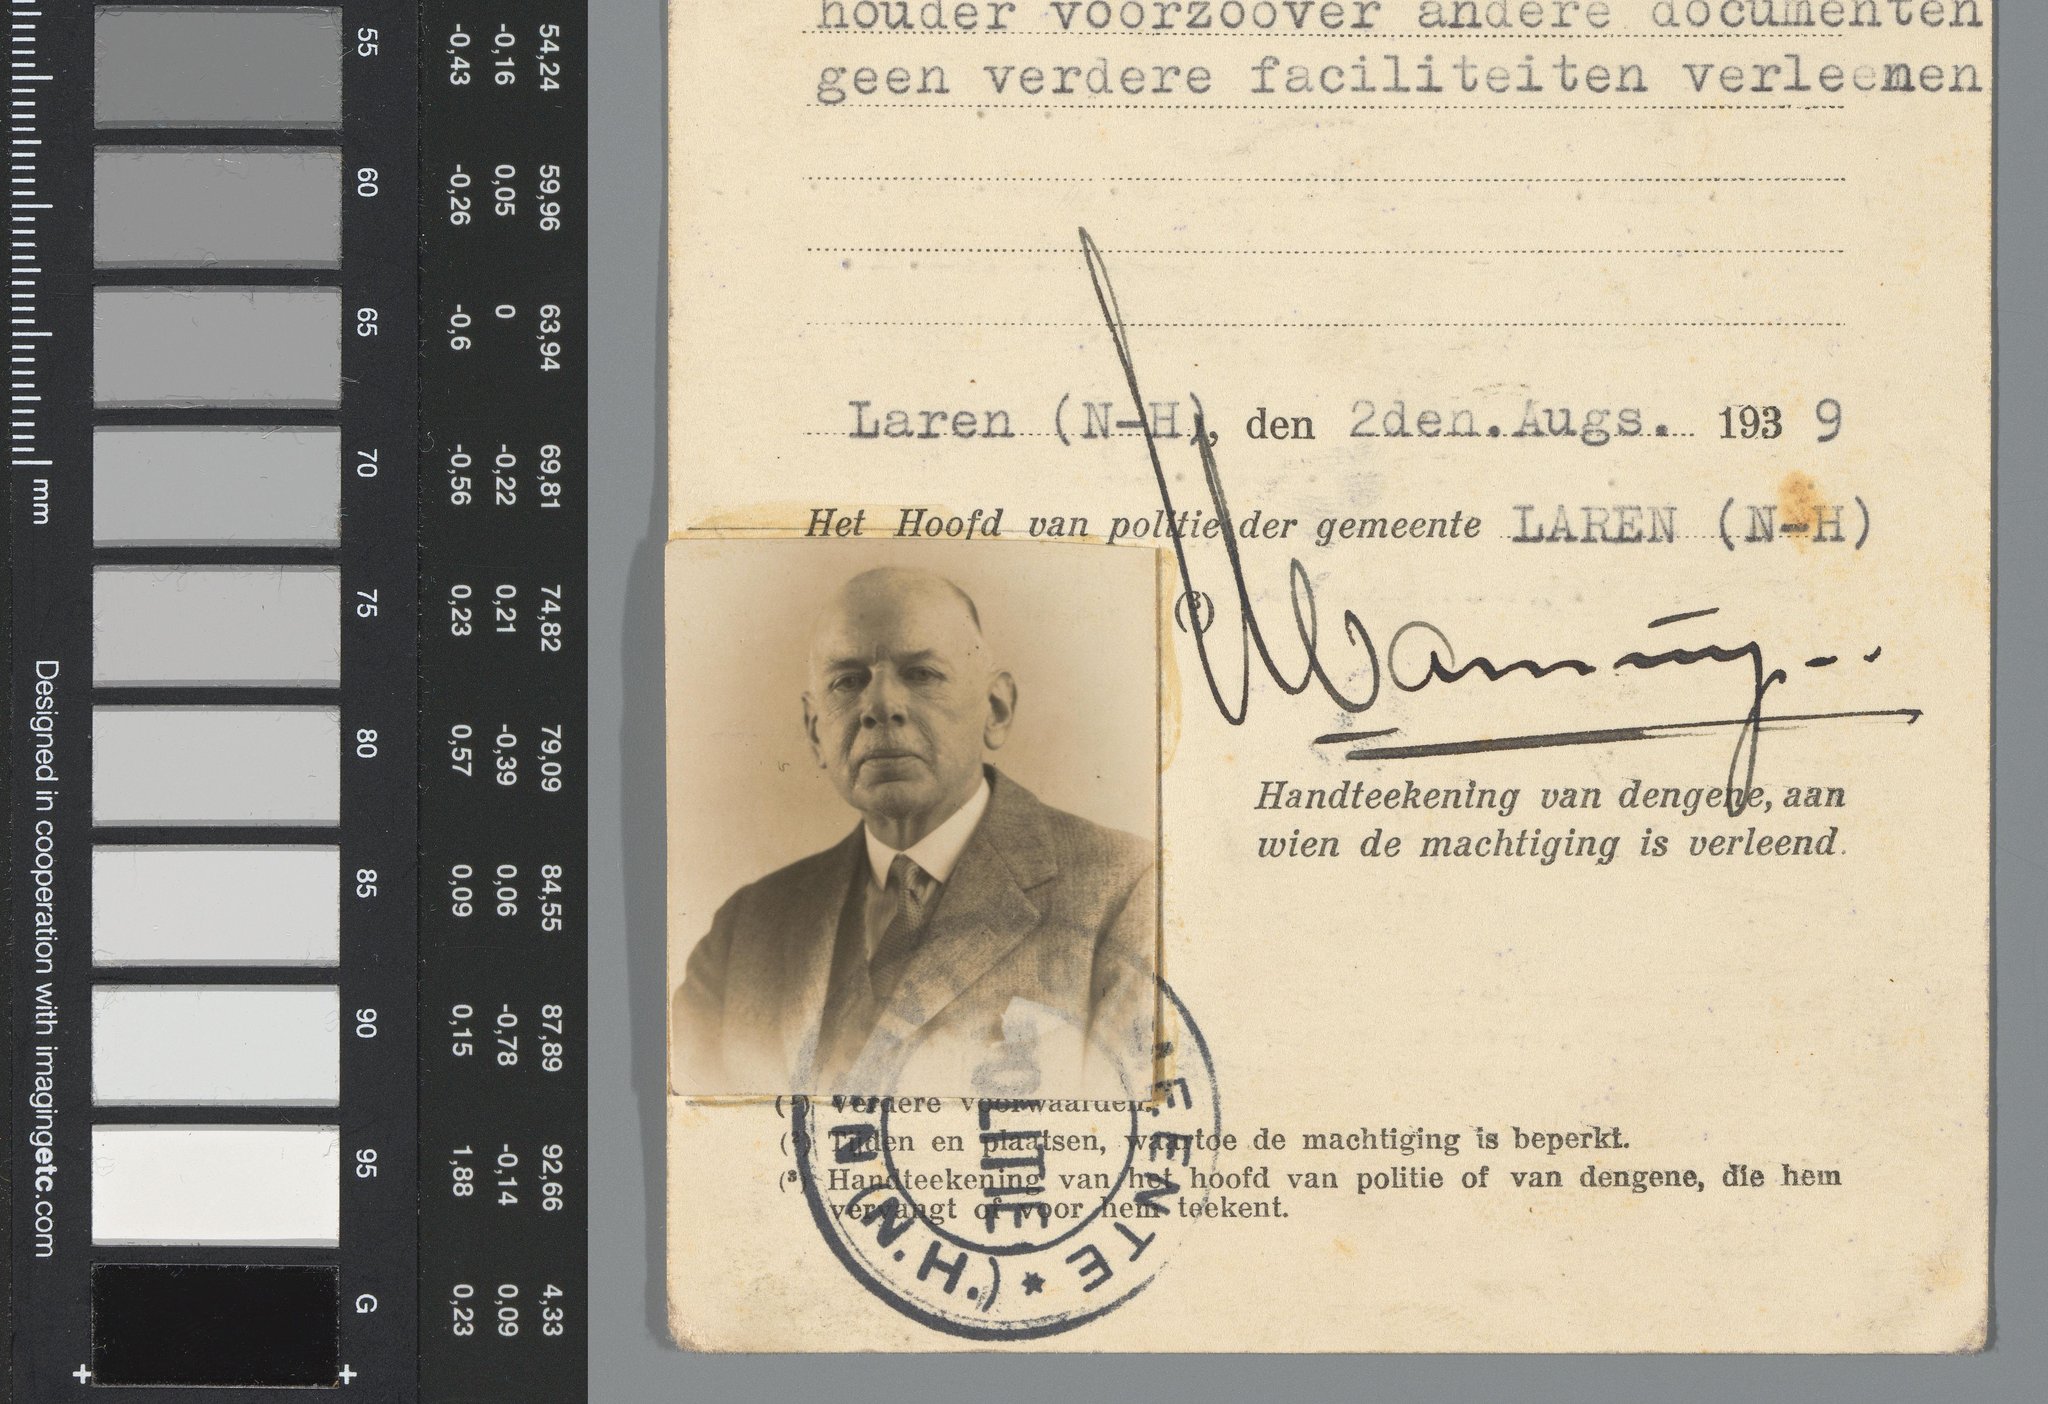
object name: passport photograph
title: Vuurwapenvergunning van Karel Frederik van den Berg afgegeven door de Gemeente Laren (NH)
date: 1939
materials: paper, photographic support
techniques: photography, printed materials, typewriting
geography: laren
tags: batavia, karel frederik van den berg